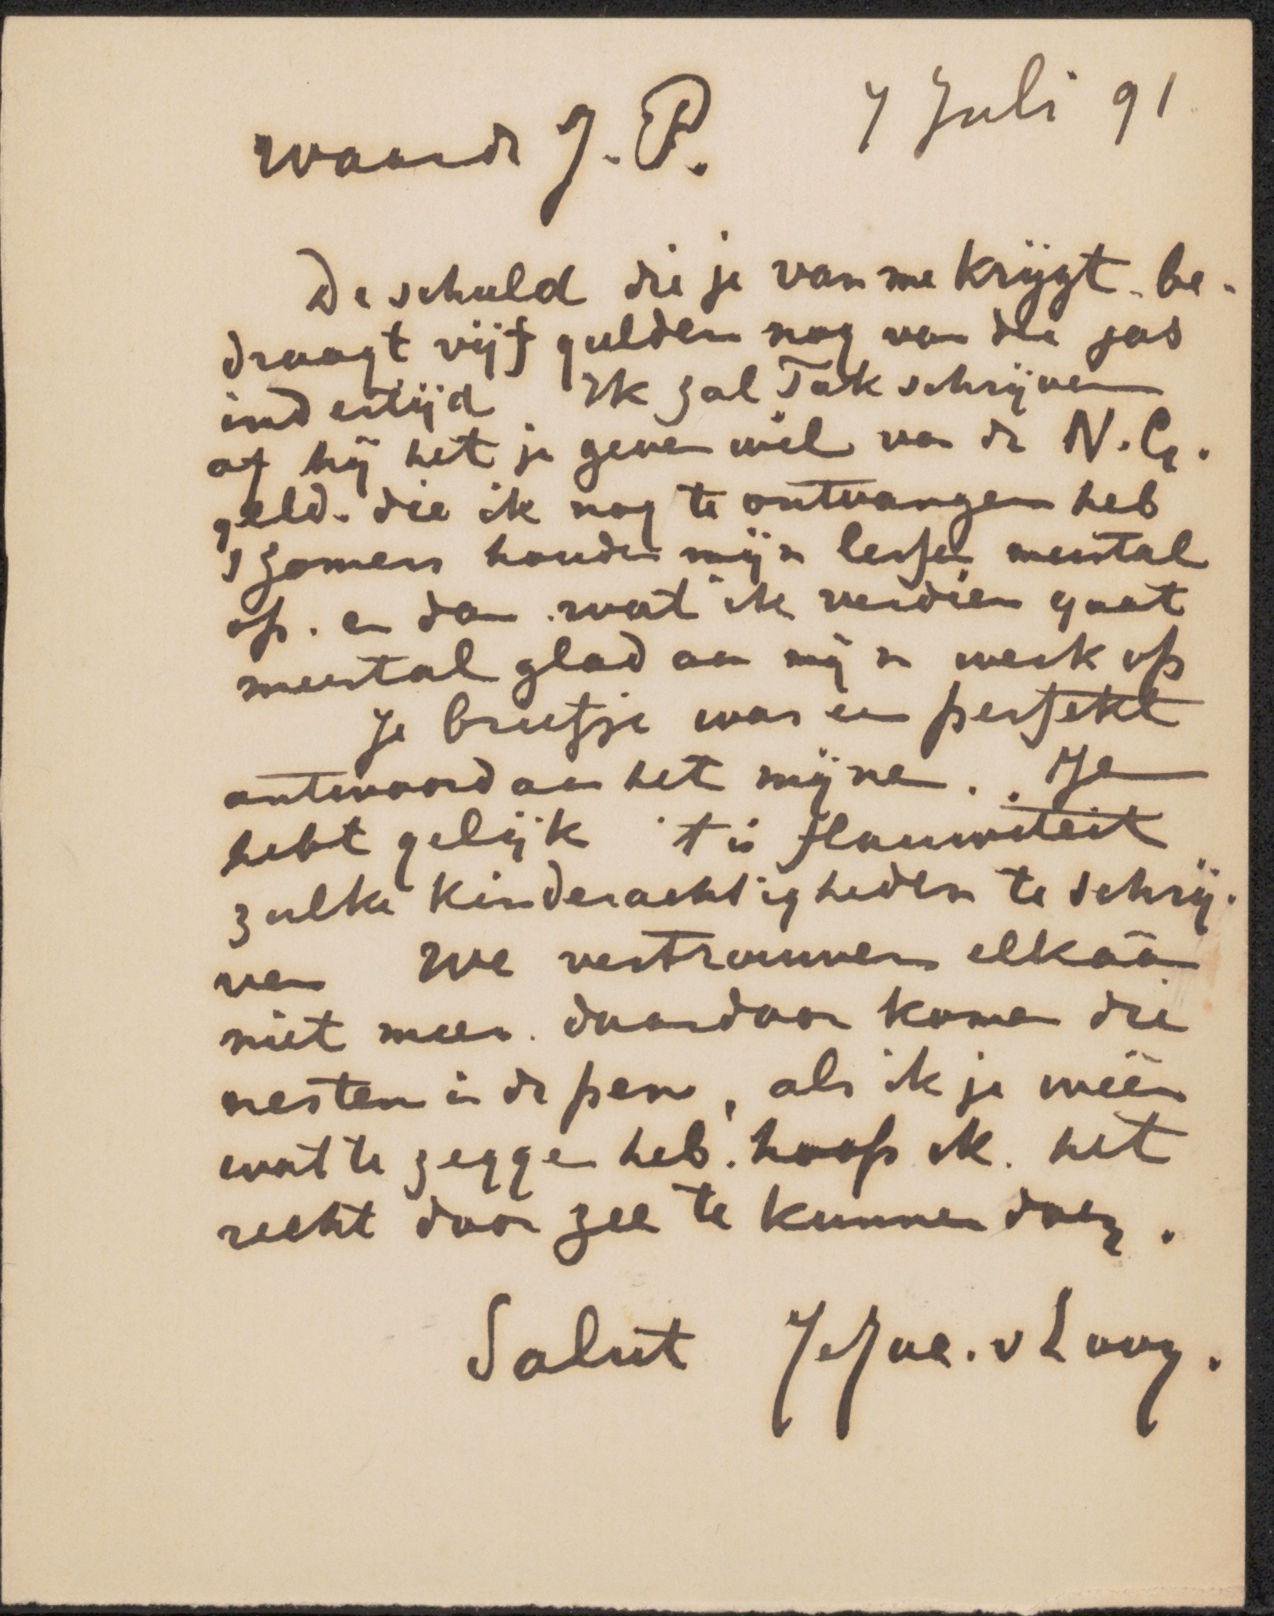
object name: letter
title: Brief aan Jan Veth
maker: jac van looij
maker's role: draughtsman, painter, print maker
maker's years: 1855-1930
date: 1865-1925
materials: ink, paper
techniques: pen, writing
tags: dordrecht, designer, jan veth, politician, pieter lodewijk tak, passions, emotions, affections, money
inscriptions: collector's mark: ‘RPK’